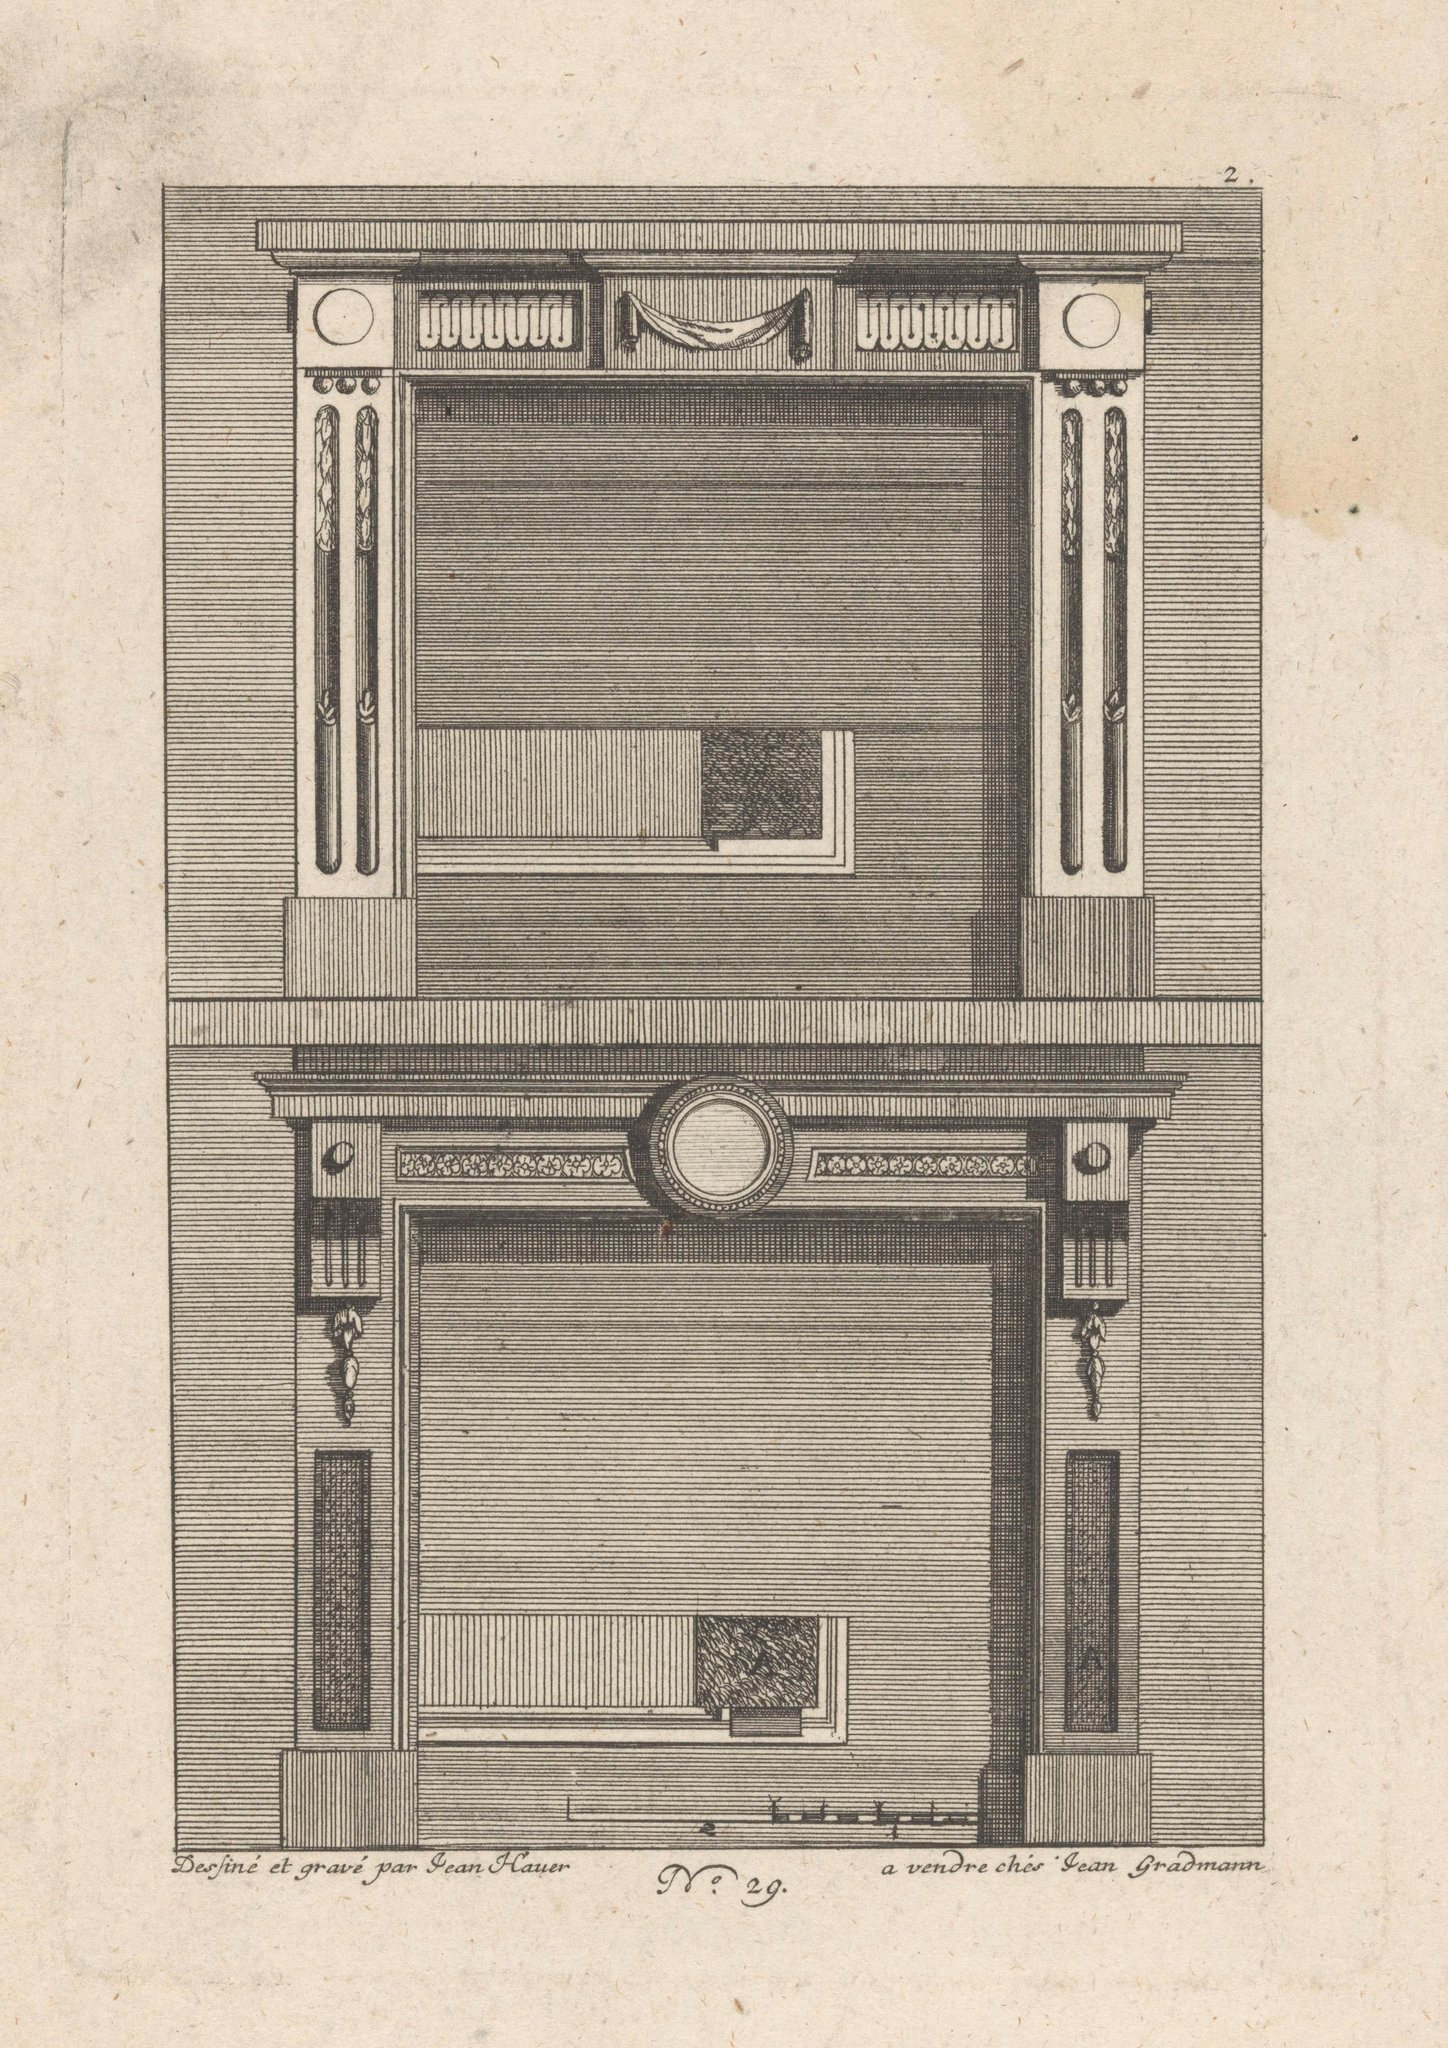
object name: ornament print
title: Twee haarden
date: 1758-1820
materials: paper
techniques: etching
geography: ravensburg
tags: open hearth, fire-place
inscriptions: collector's mark: Lugt 2760, collector's mark: Lugt 2228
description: Ontwerpen voor twee geornamenteerde haarden. Uitgeversnummer 29.